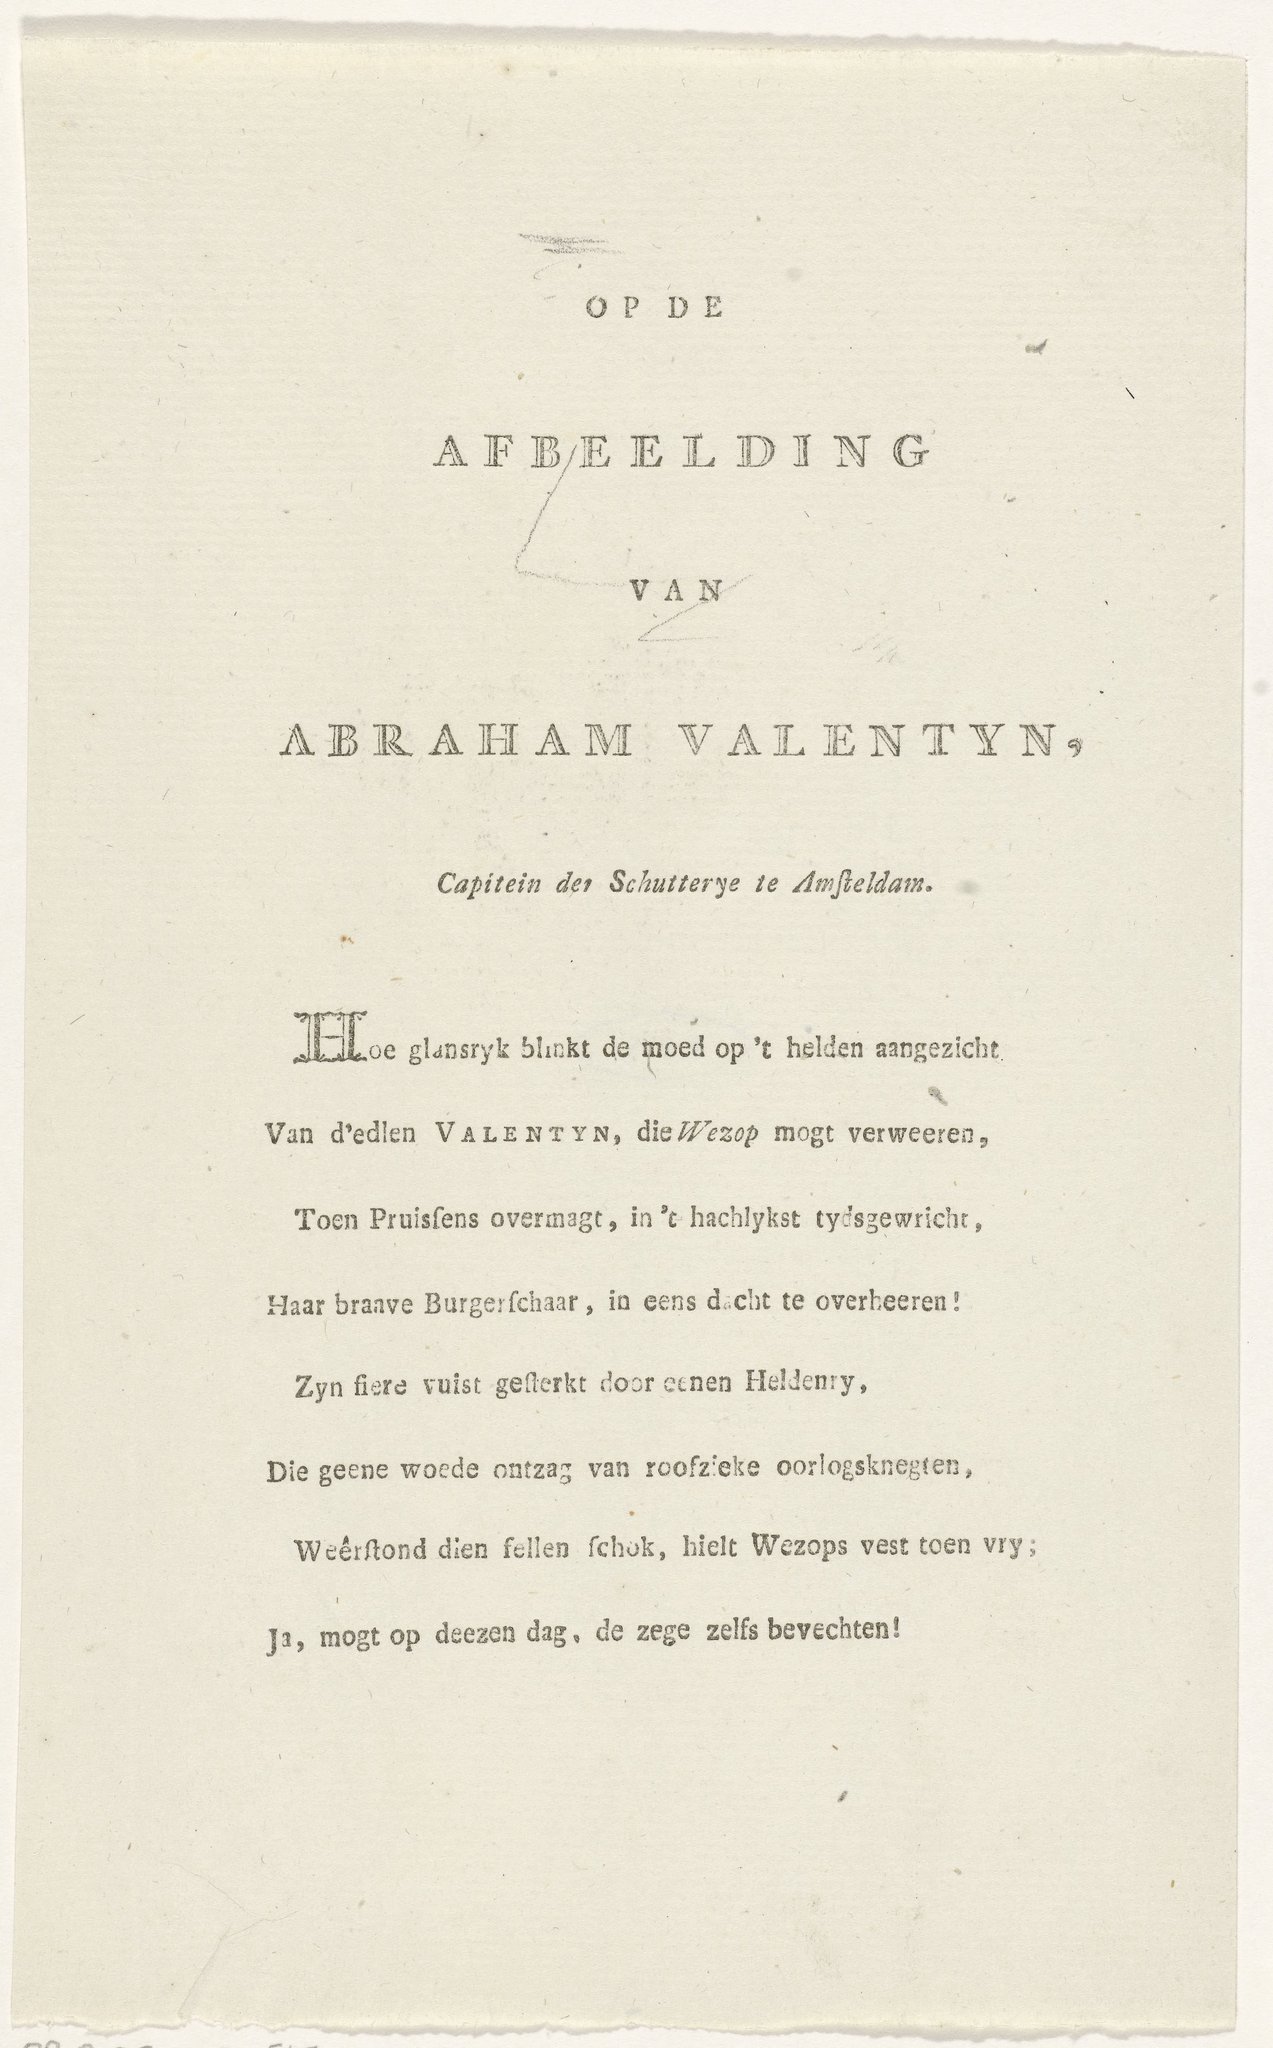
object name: print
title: Tekst op de afbeelding van Abraham Valentijn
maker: Anonymous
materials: paper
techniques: letterpress printing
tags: kapitein, abraham valentijn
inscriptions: collector's mark: Lugt 2228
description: Blad waarschijnlijk uit: Nomsz, Johannes. Vaderlandsche Chocolaad. Amsterdam, Dirk Meland Langeveld, 1796.